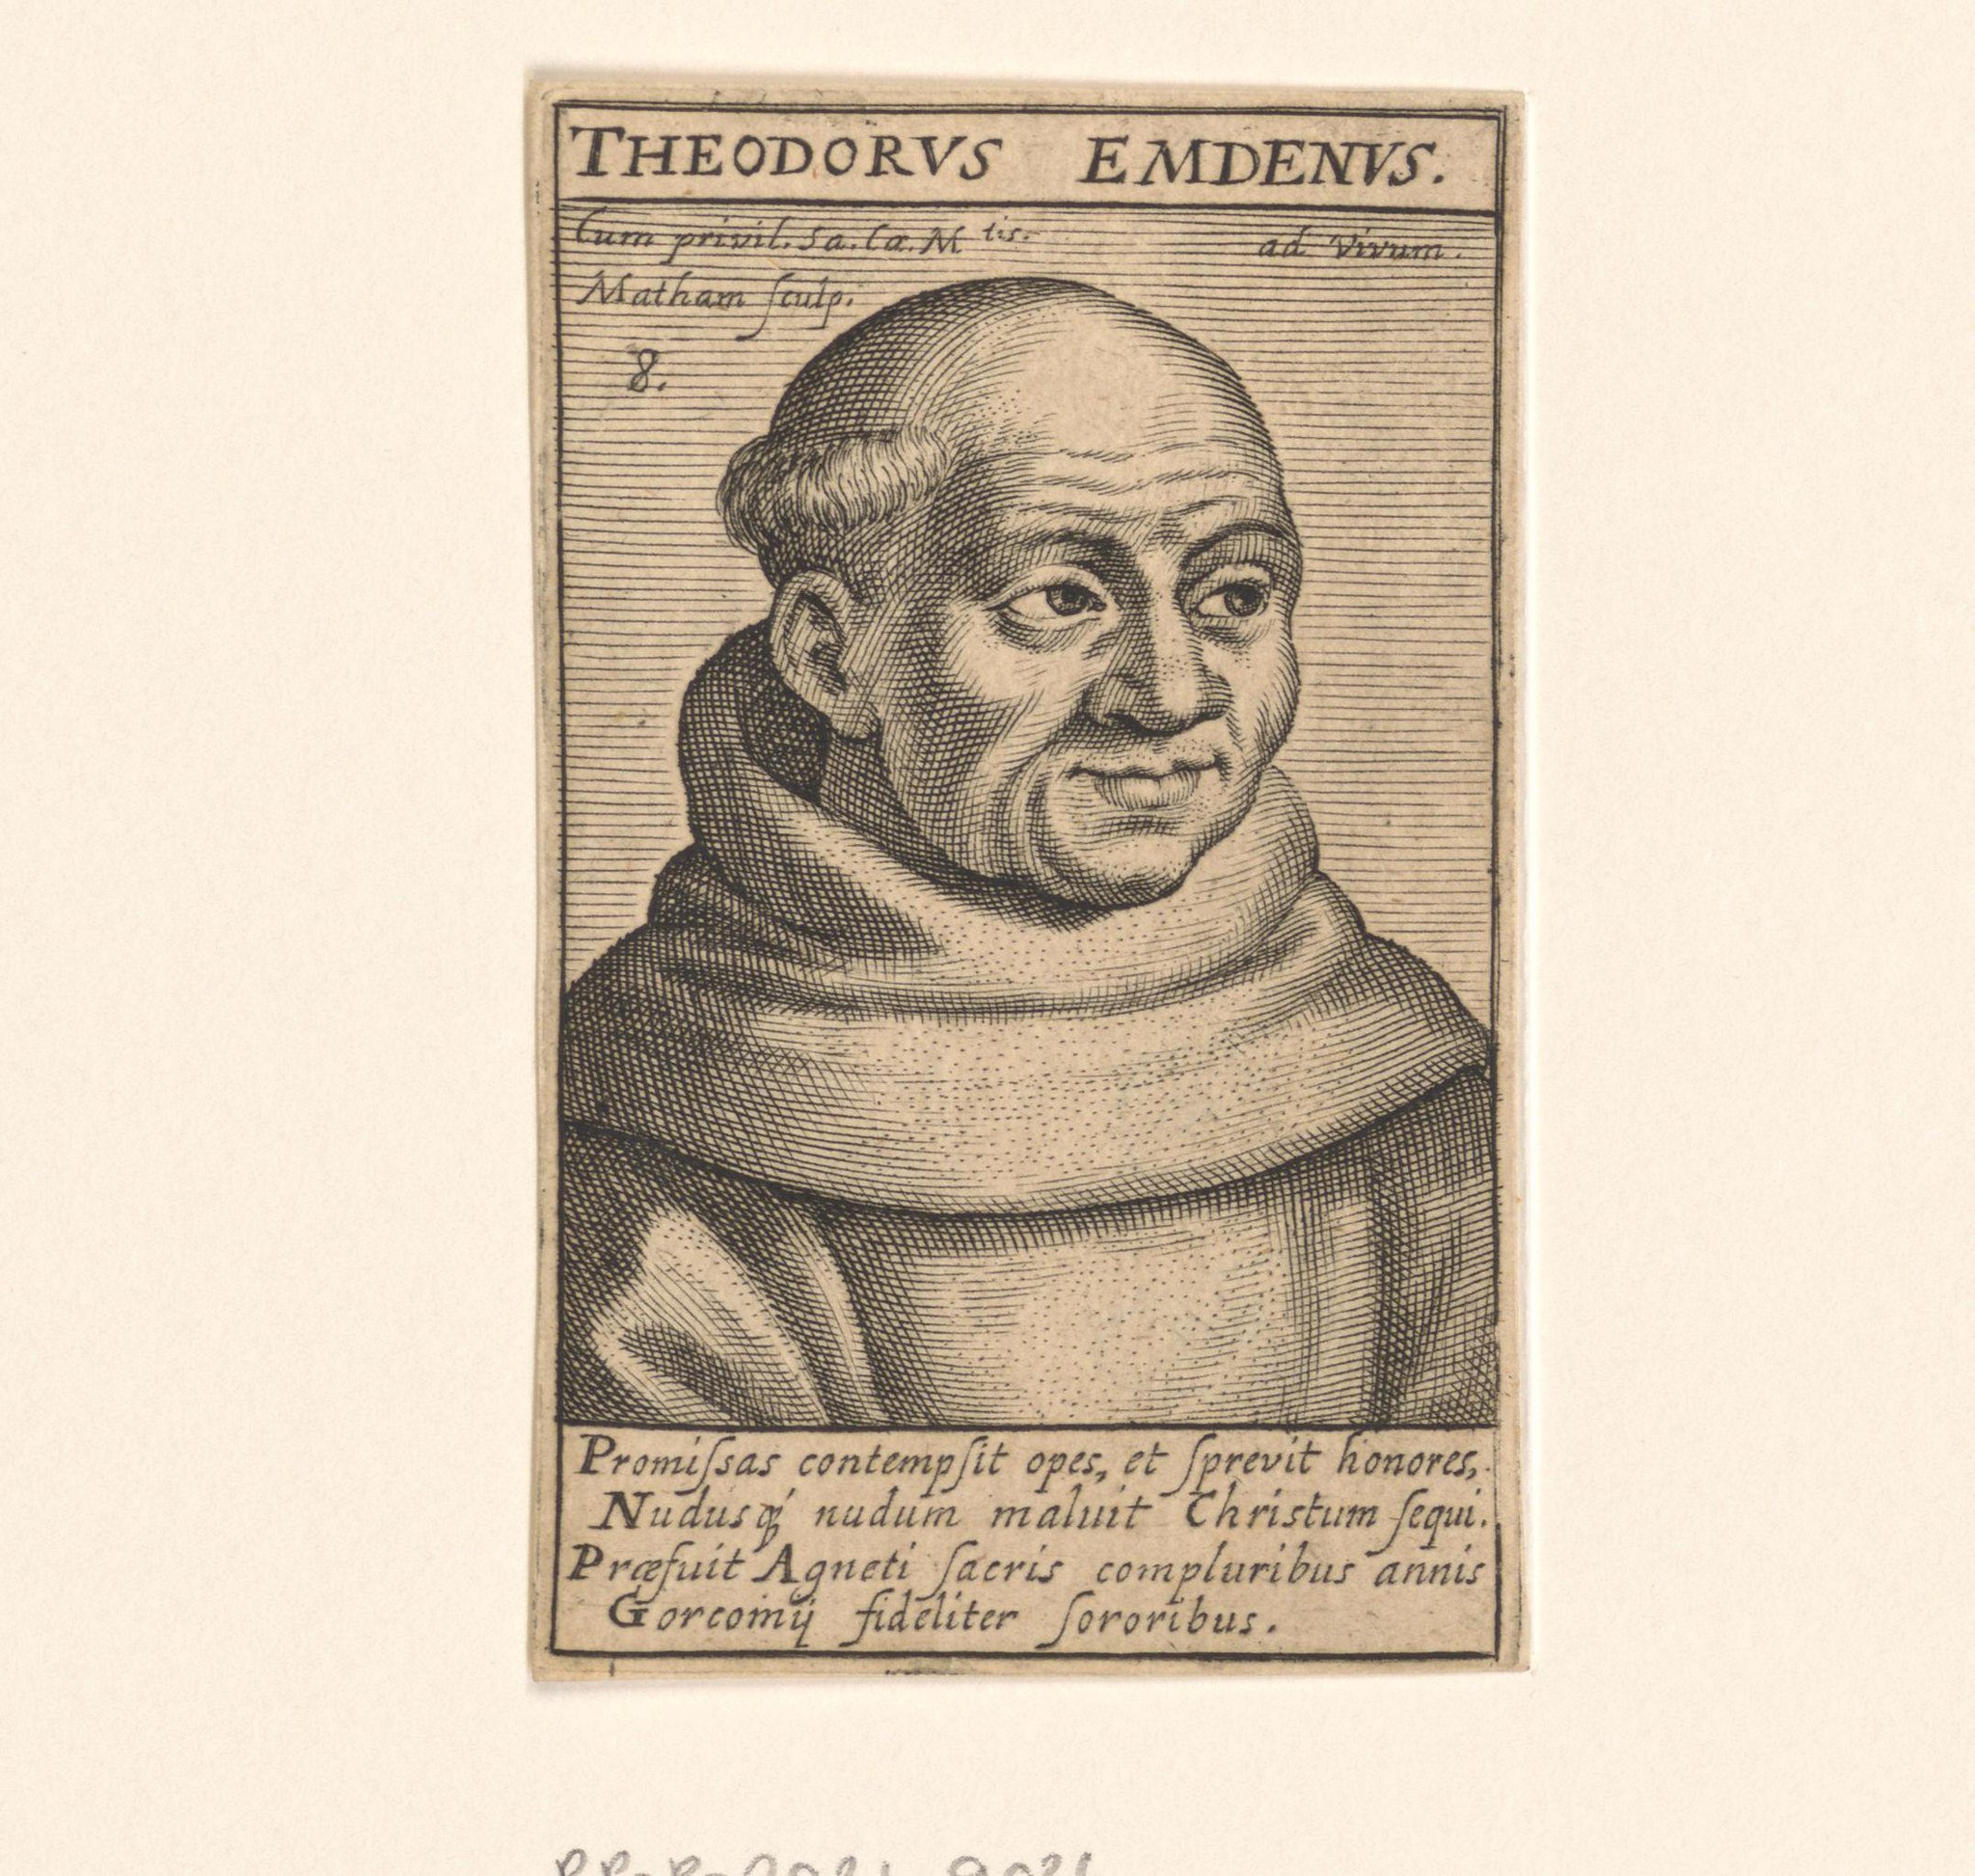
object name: print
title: Martelaren van Gorcum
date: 1617-1618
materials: paper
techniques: engraving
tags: brielle, historical persons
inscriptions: collector's mark: Lugt 2228, collector's mark: Lugt 963